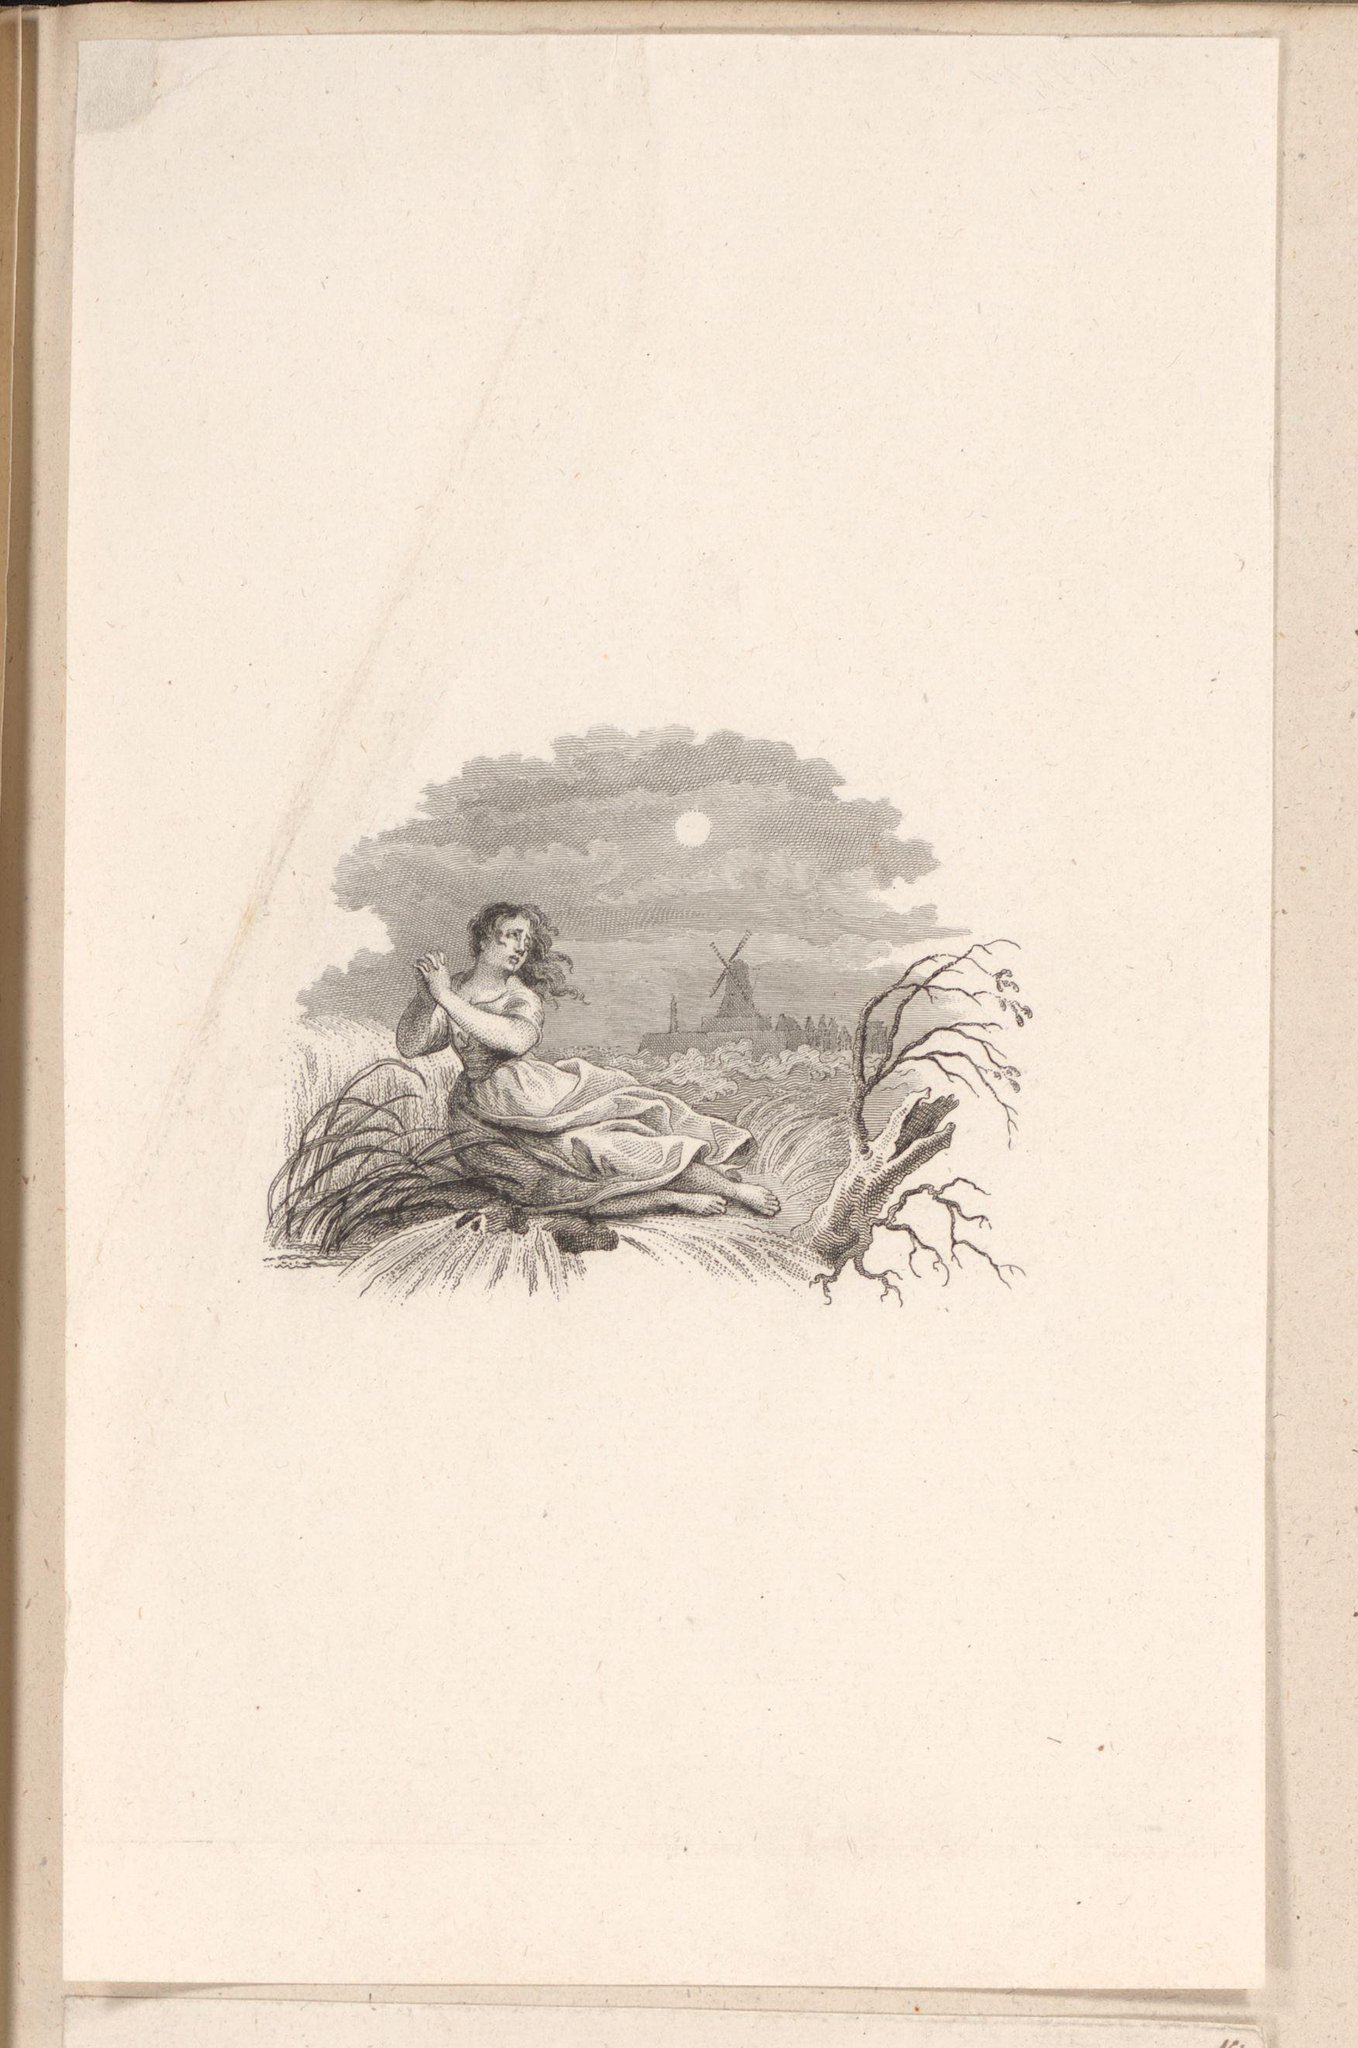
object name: album leaf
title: Smekende vrouw bij nacht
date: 1771-1818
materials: paper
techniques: engraving, etching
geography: haarlem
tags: night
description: Een korenveld met een treurige vrouw. Ze heeft haar handen gevouwen en kijkt naar de maan. Op de achtergrond een molen. De prent maakt deel uit van een album.